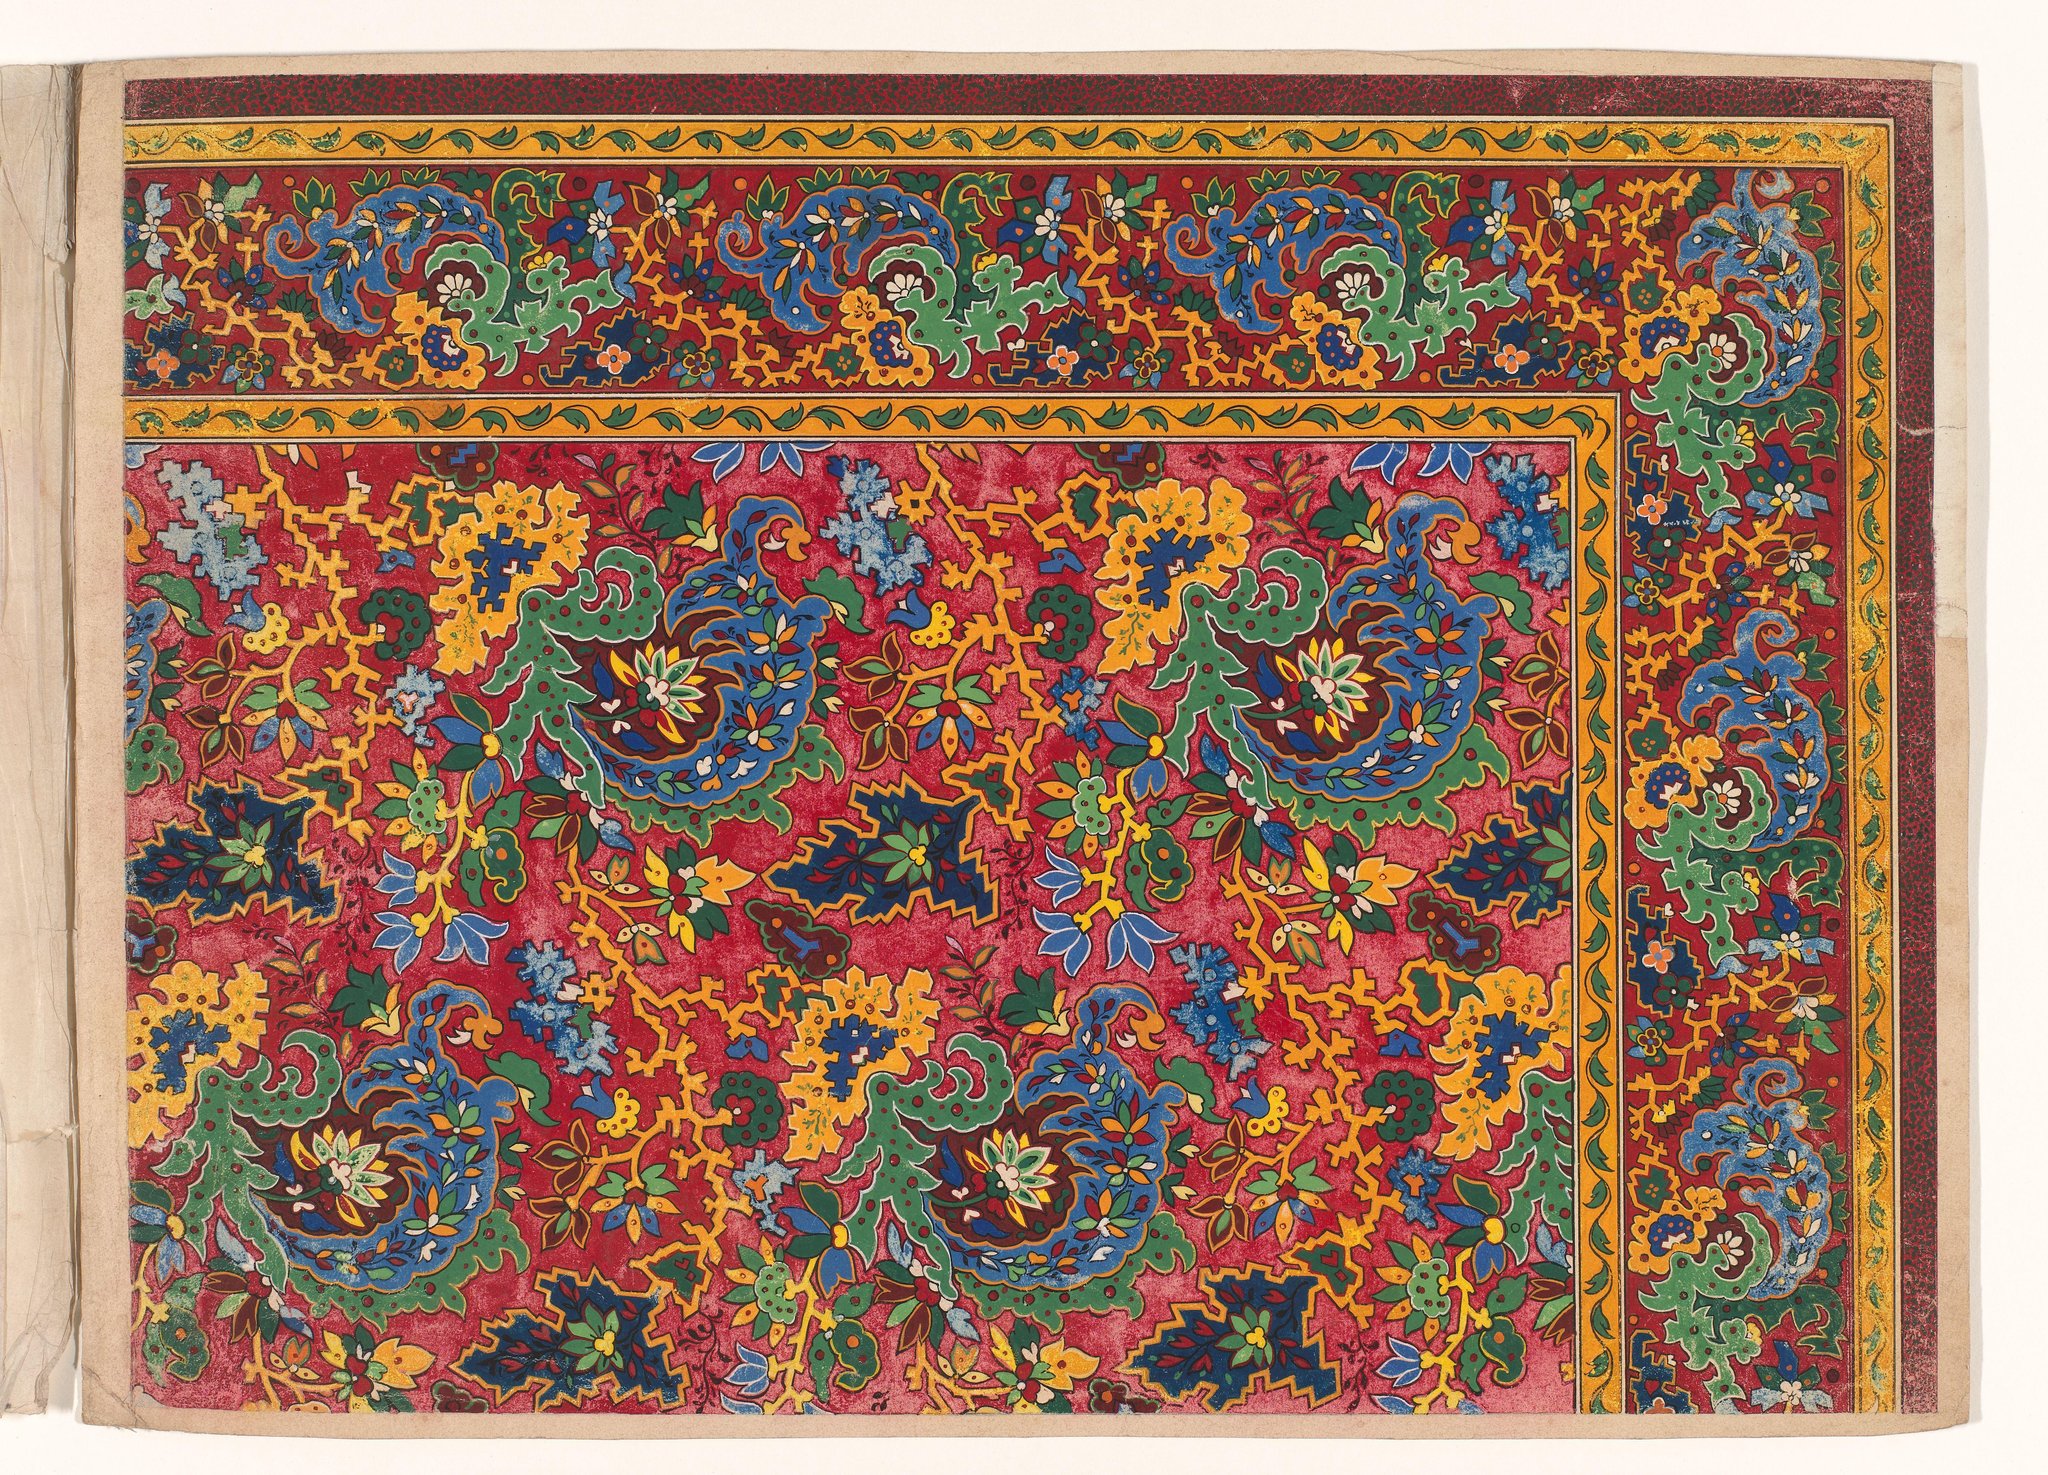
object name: design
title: Ontwerp voor een tapijt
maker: Anonymous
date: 1854-1864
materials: gouache, paper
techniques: brush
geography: amsterdam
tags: ornaments ~ art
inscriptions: retailer's mark: ‘JHS.’, inscription: ‘V’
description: De presentatietekeningen BK-1971-77-1 t/m 86 zijn kopieën van de originele ontwerptekeningen. Ze werden gemaakt voor vertegenwoordigers van bijvoorbeeld magazijnen, die ze aan hun klanten konden tonen. De meeste tekeningen tonen een kwart van het dessin inclusief rand, middenpartij (de zogenaamde grond of fond) en centraal medaillon. Door het gebruik van spiegels kan de illusie van het gehele tapijt worden opgeroepen. Een deel van de tekeningen heeft een alfabetische opeenvolgende letter als kenmerk, de andere groep een cijfer.Waarschijnlijk is de reeks dessins met een letter eerder samengesteld dan de genummerde tekeningen.